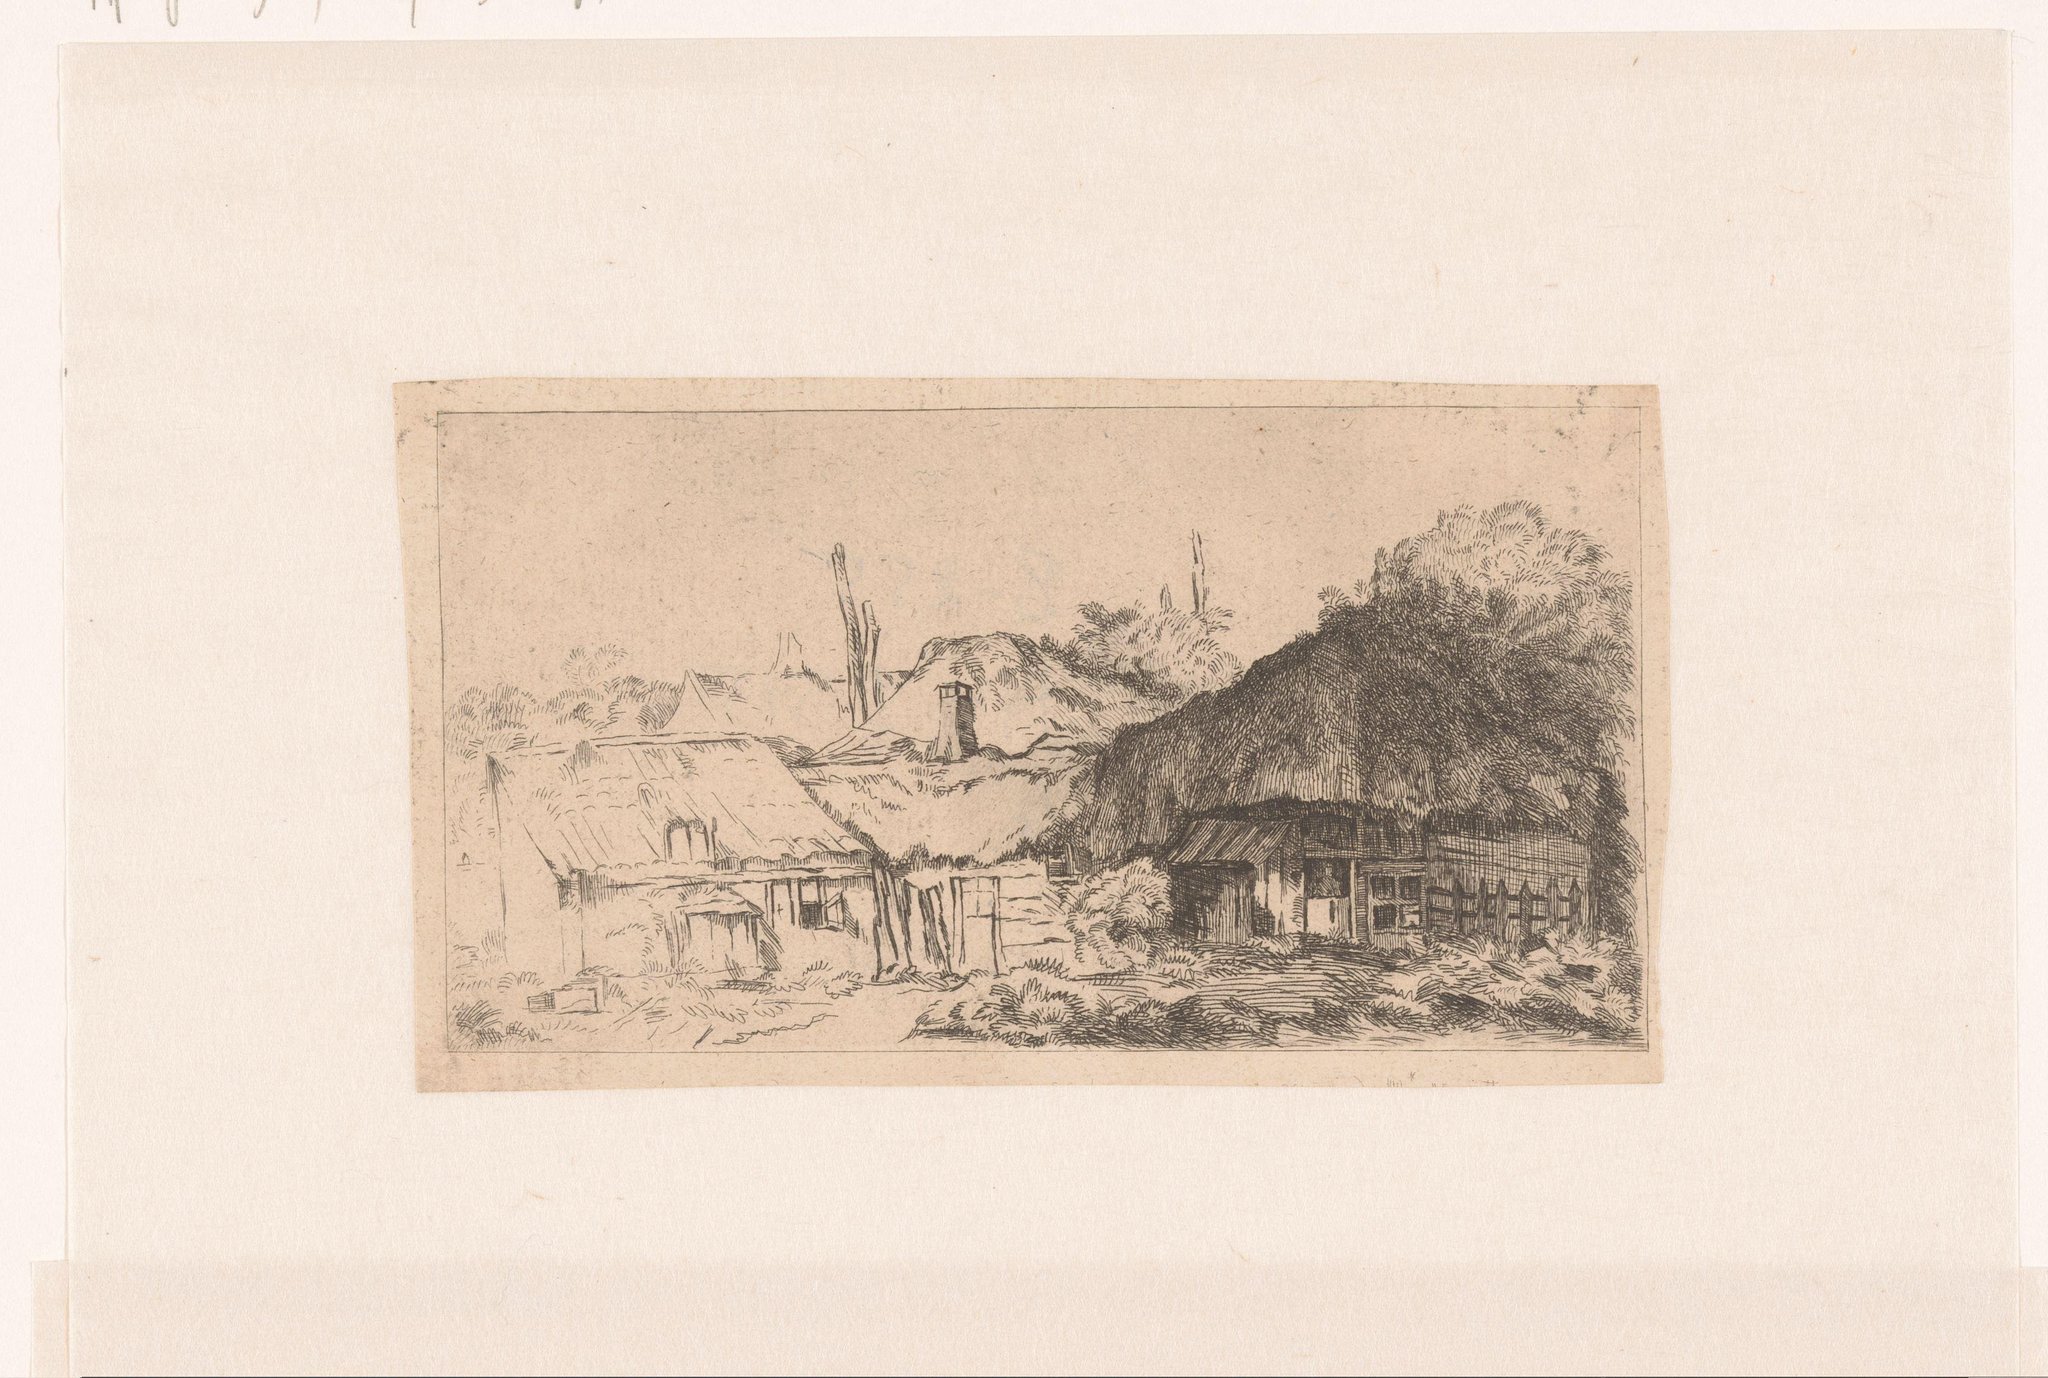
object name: print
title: Onvoltooid landschap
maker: pierre françois basan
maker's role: print maker, publisher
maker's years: 1723-1797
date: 1733-1797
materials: paper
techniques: etching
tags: landscapes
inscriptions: collector's mark: Lugt 2760, collector's mark: Lugt 2228